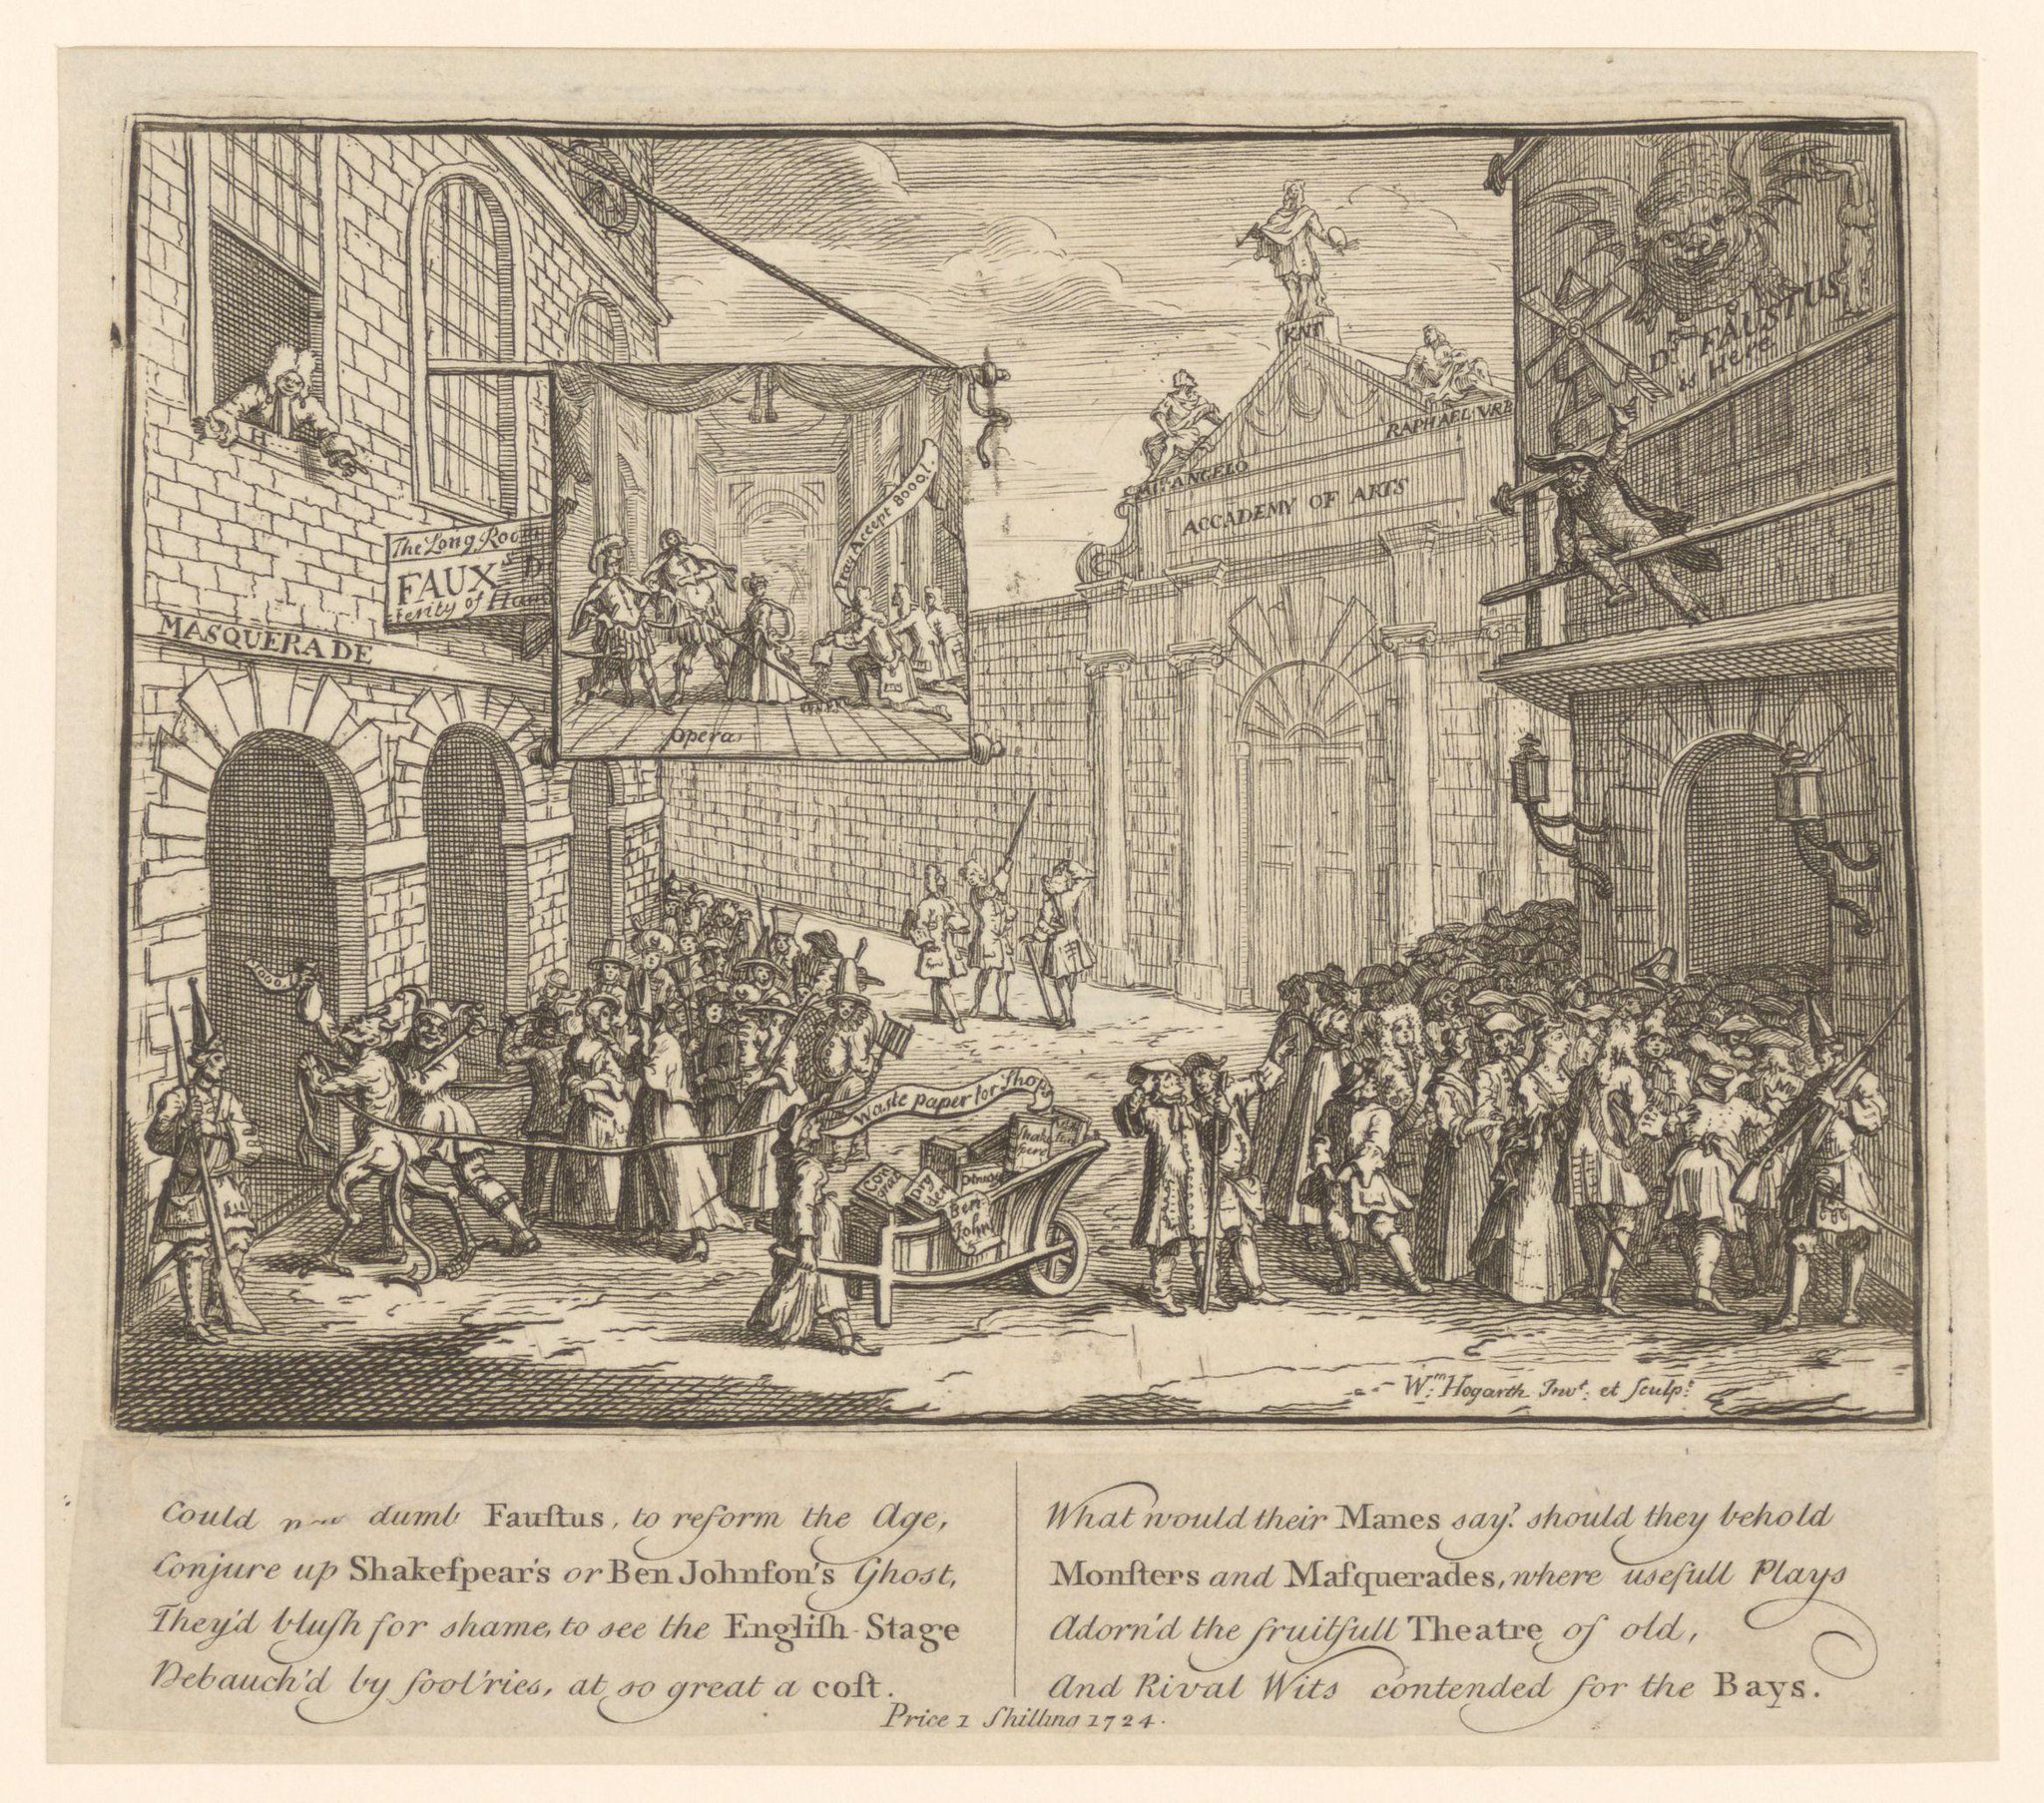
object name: print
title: Masquerades and Operas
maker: william hogarth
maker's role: draughtsman, painter, print maker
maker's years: 1697-1764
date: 1724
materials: paper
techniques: engraving, etching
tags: recreation, amusement, operetta, musical, 'singspiel', pantomime, dumb show, masque, political caricatures and satires, london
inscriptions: collector's mark: Lugt 2228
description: Tekst in het Engels in de ondermarge. Links begeleidt een duivel een menigte van een maskeradebal, georganiseerd door John James Heidegger, naar de opera, rechts een lange rij voor de entree van het Rich's Lincoln's Inn Fields Theatre waar Doctor Faustus wordt uitgevoerd. Achteraan de Royal Academy of Arts in het huis van Lord Burlington in Piccadilly Londen, waar slechts drie mannen naar kijken. Deze prent impliceert een verschil tussen hoge en lage cultuur en 'de slechte smaak' in Londen.